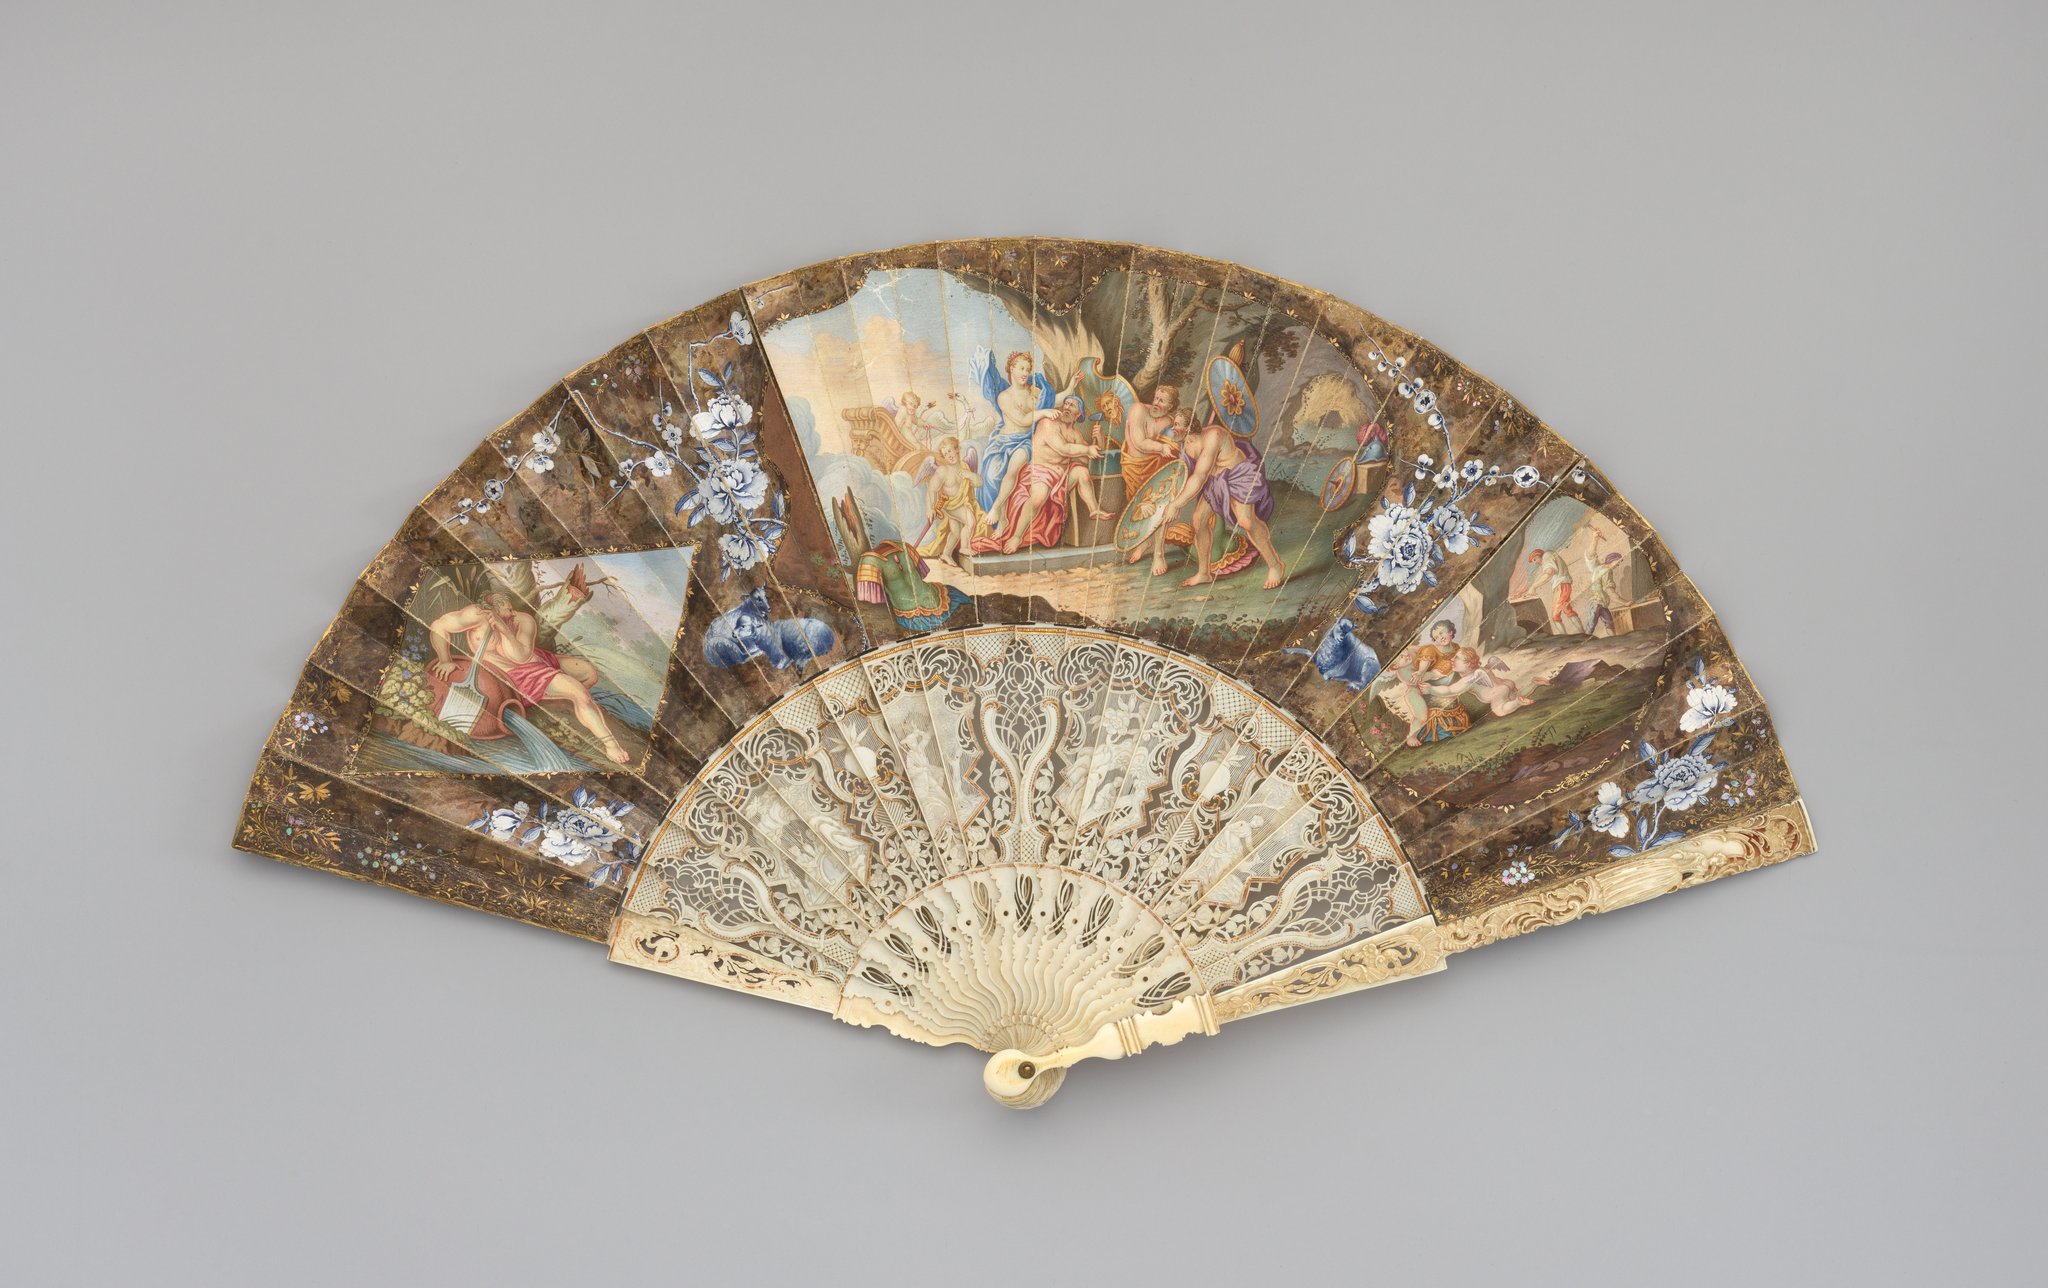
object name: fan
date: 1701-1800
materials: ivory, mother of pearl, paper